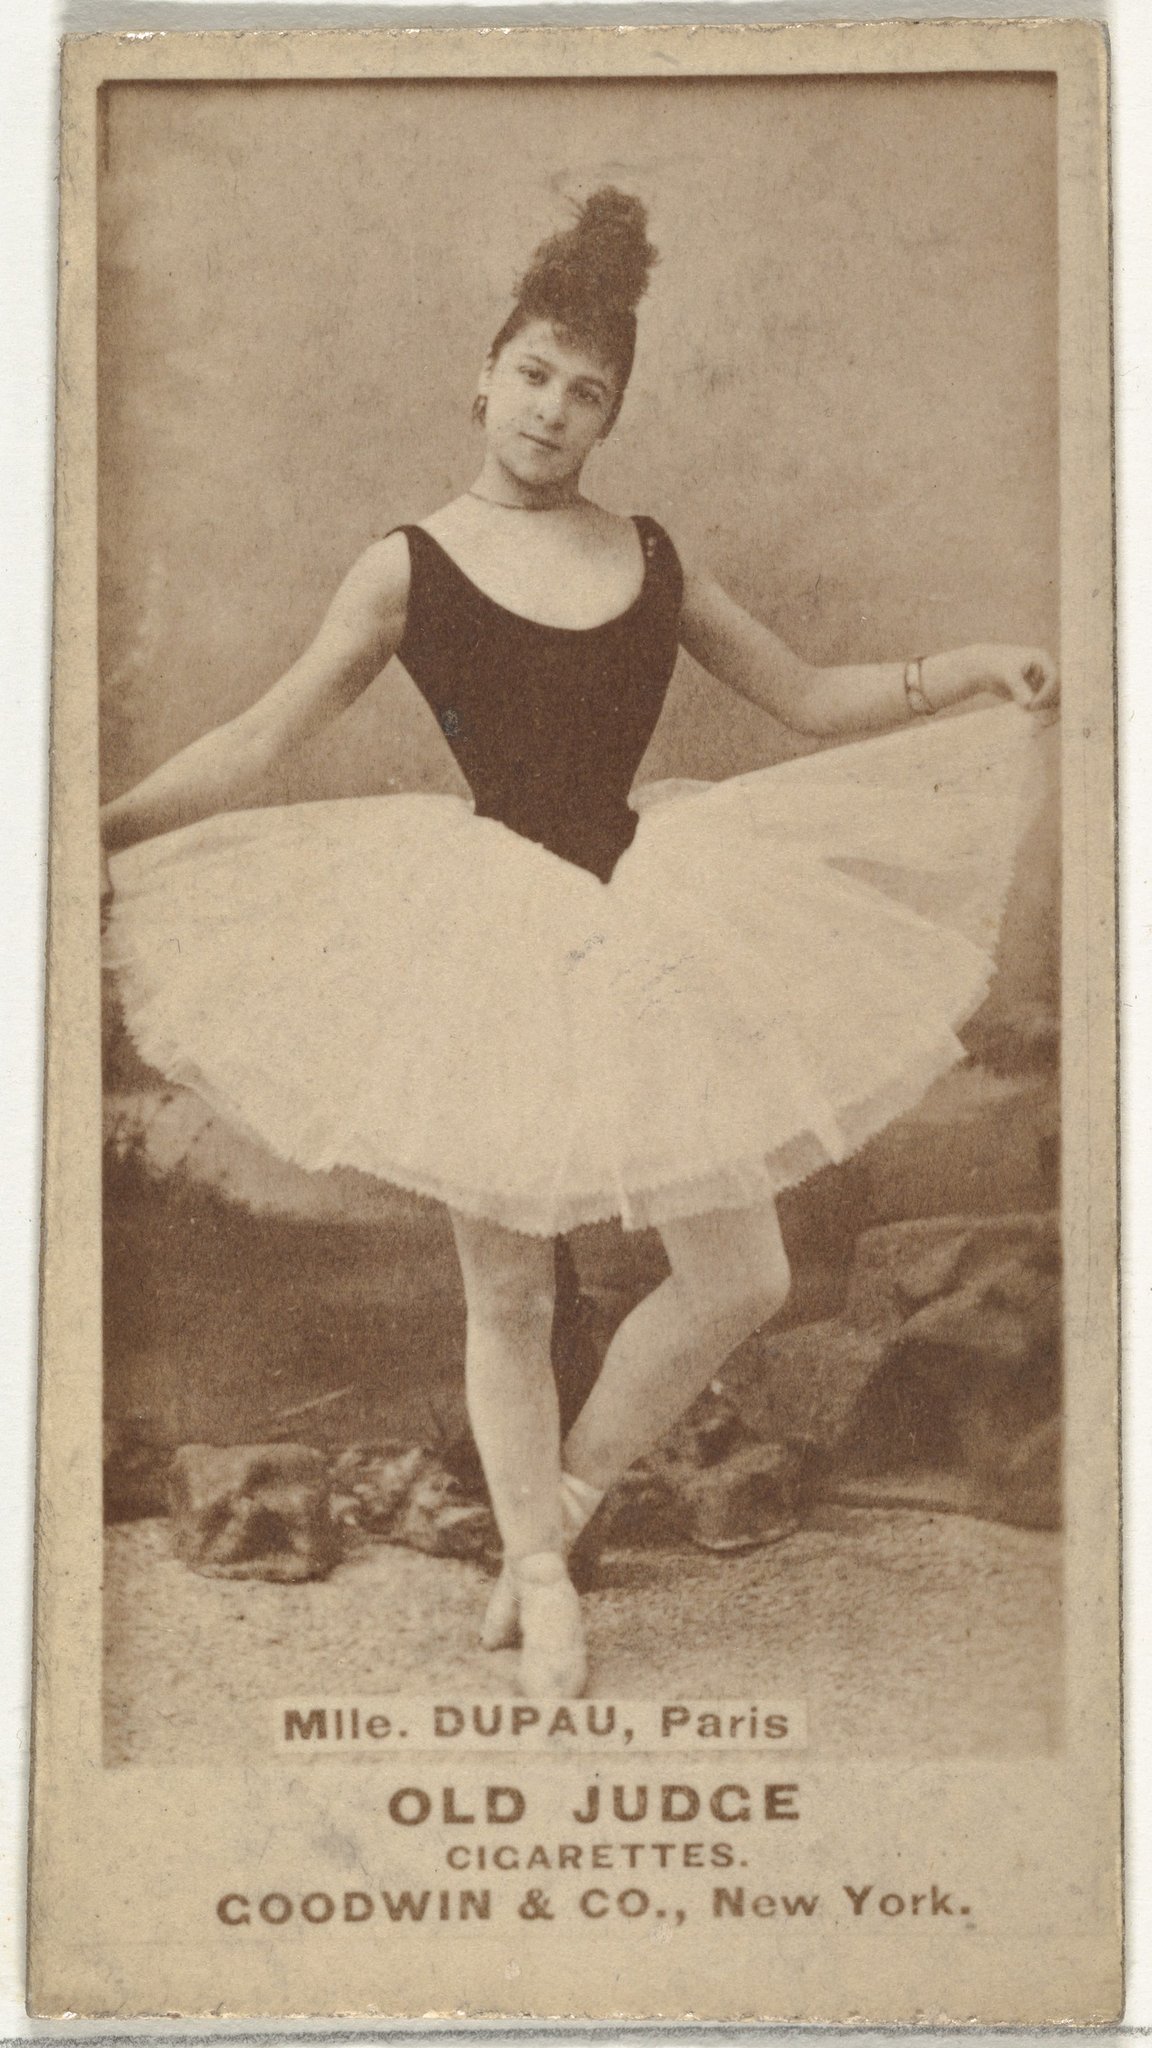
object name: photograph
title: Mlle. Dupau, Paris, from the Actors and Actresses series (N171) for Old Judge Cigarettes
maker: goodwin & company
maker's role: publisher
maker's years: 1850-1950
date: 1886-1890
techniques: albumen silver print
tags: portraits,women,actresses